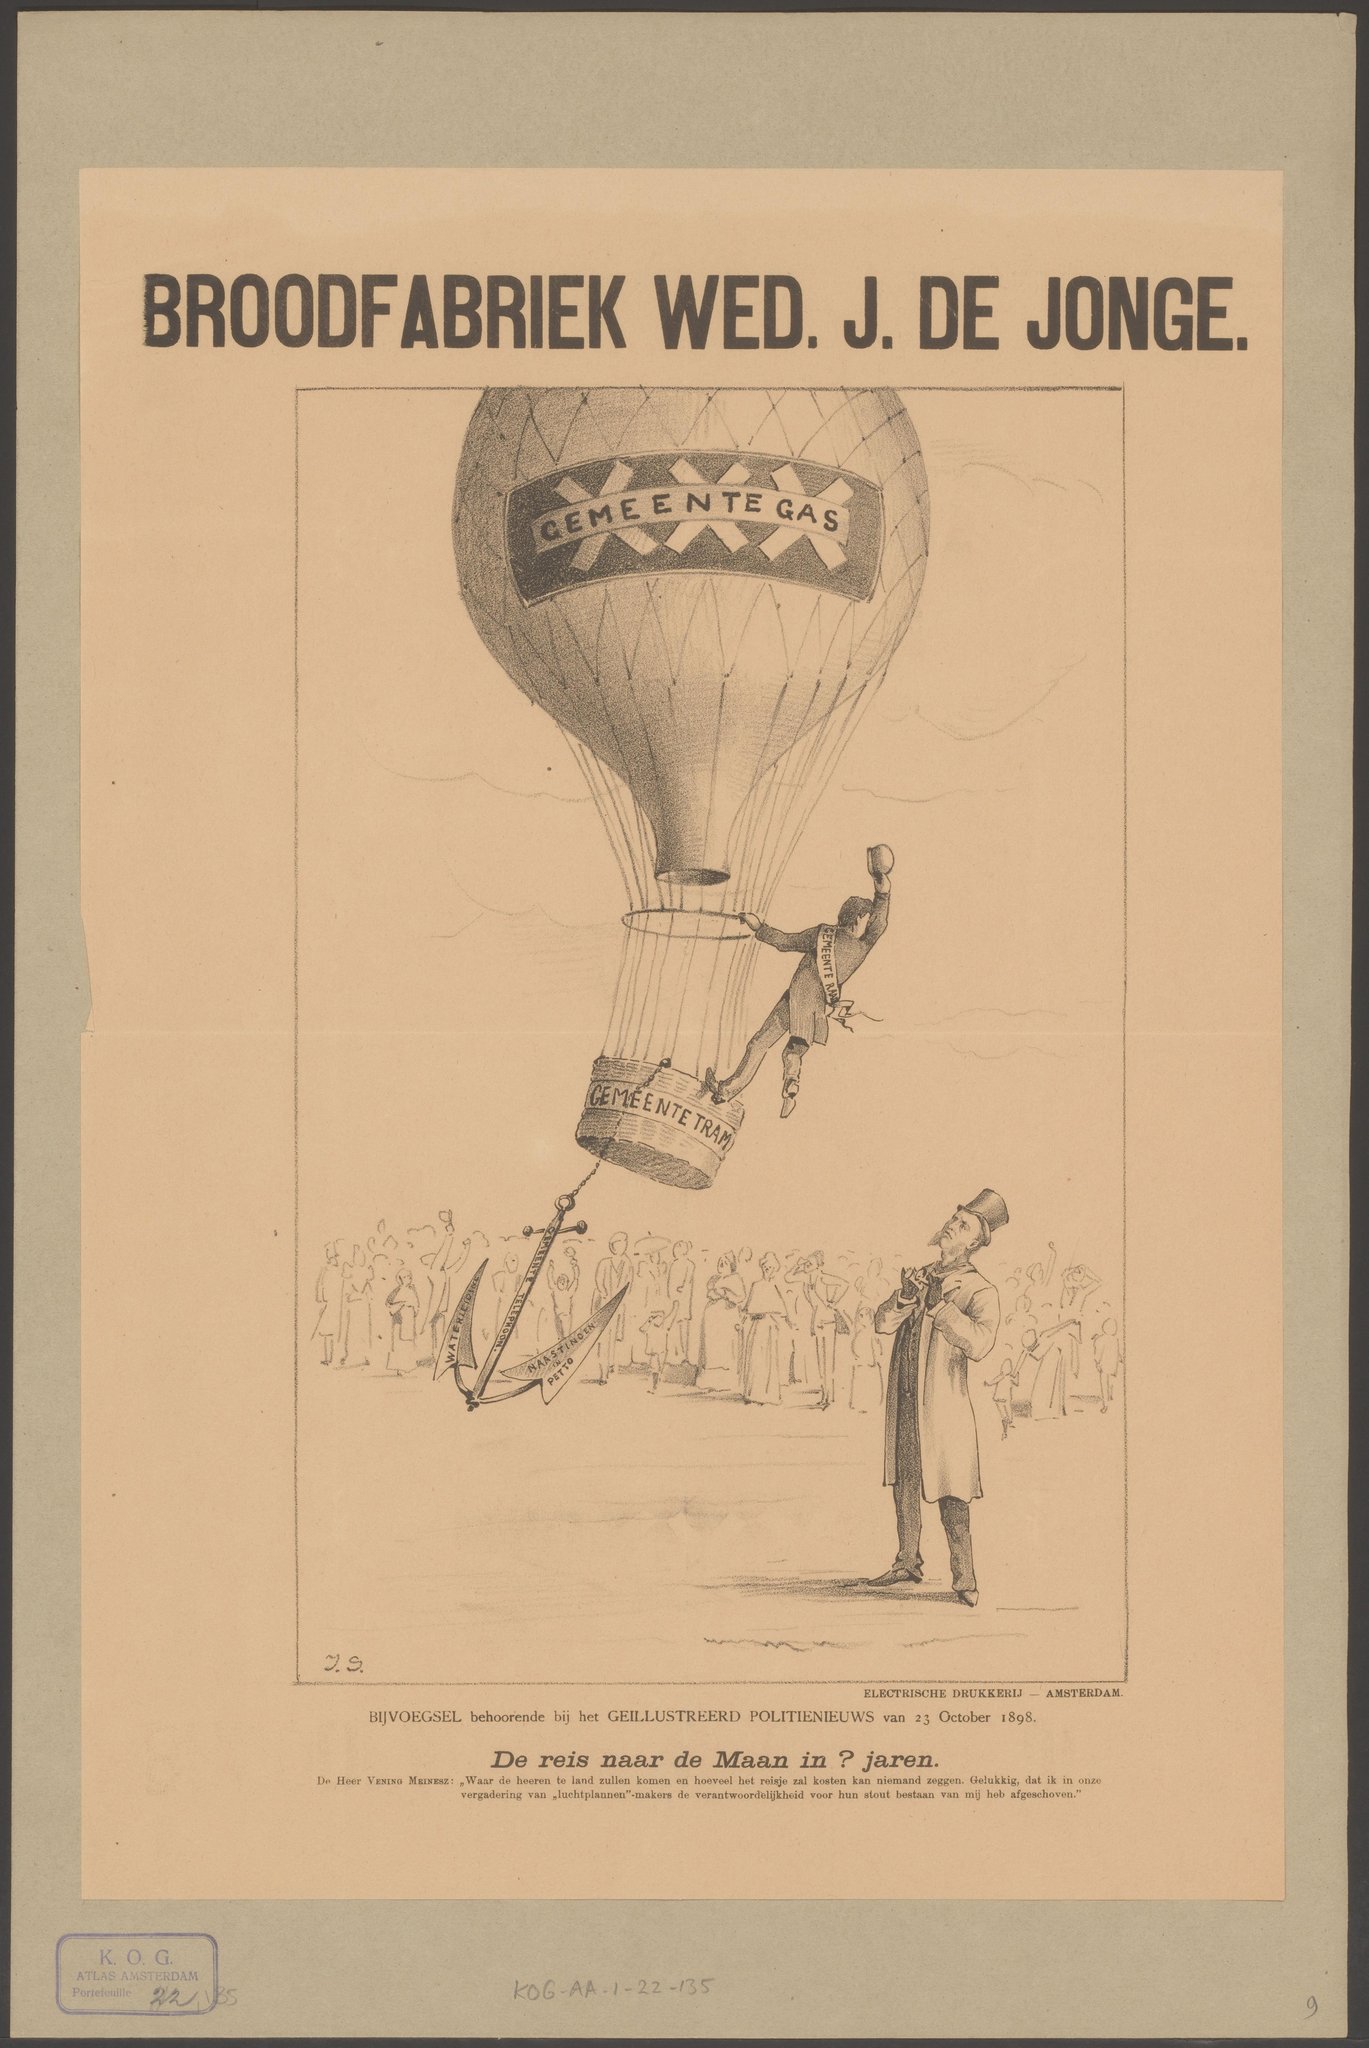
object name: cartoon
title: Sjoerd Vening Meinesz kijkt op naar een luchtballon met een anker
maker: jan sluijters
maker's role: draughtsman, print maker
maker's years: 1881-1957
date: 1898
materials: paper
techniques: letterpress printing, lithograph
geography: netherlands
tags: harlingen, politician, balloon (aviation), parts of ship's exterior: anchor, political caricatures and satires, amsterdam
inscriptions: collector's mark: Lugt 1641b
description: Gepubliceerd als bijvoegsel van 'Het Geïllustreerd Politienieuws', 23 oktober 1898.